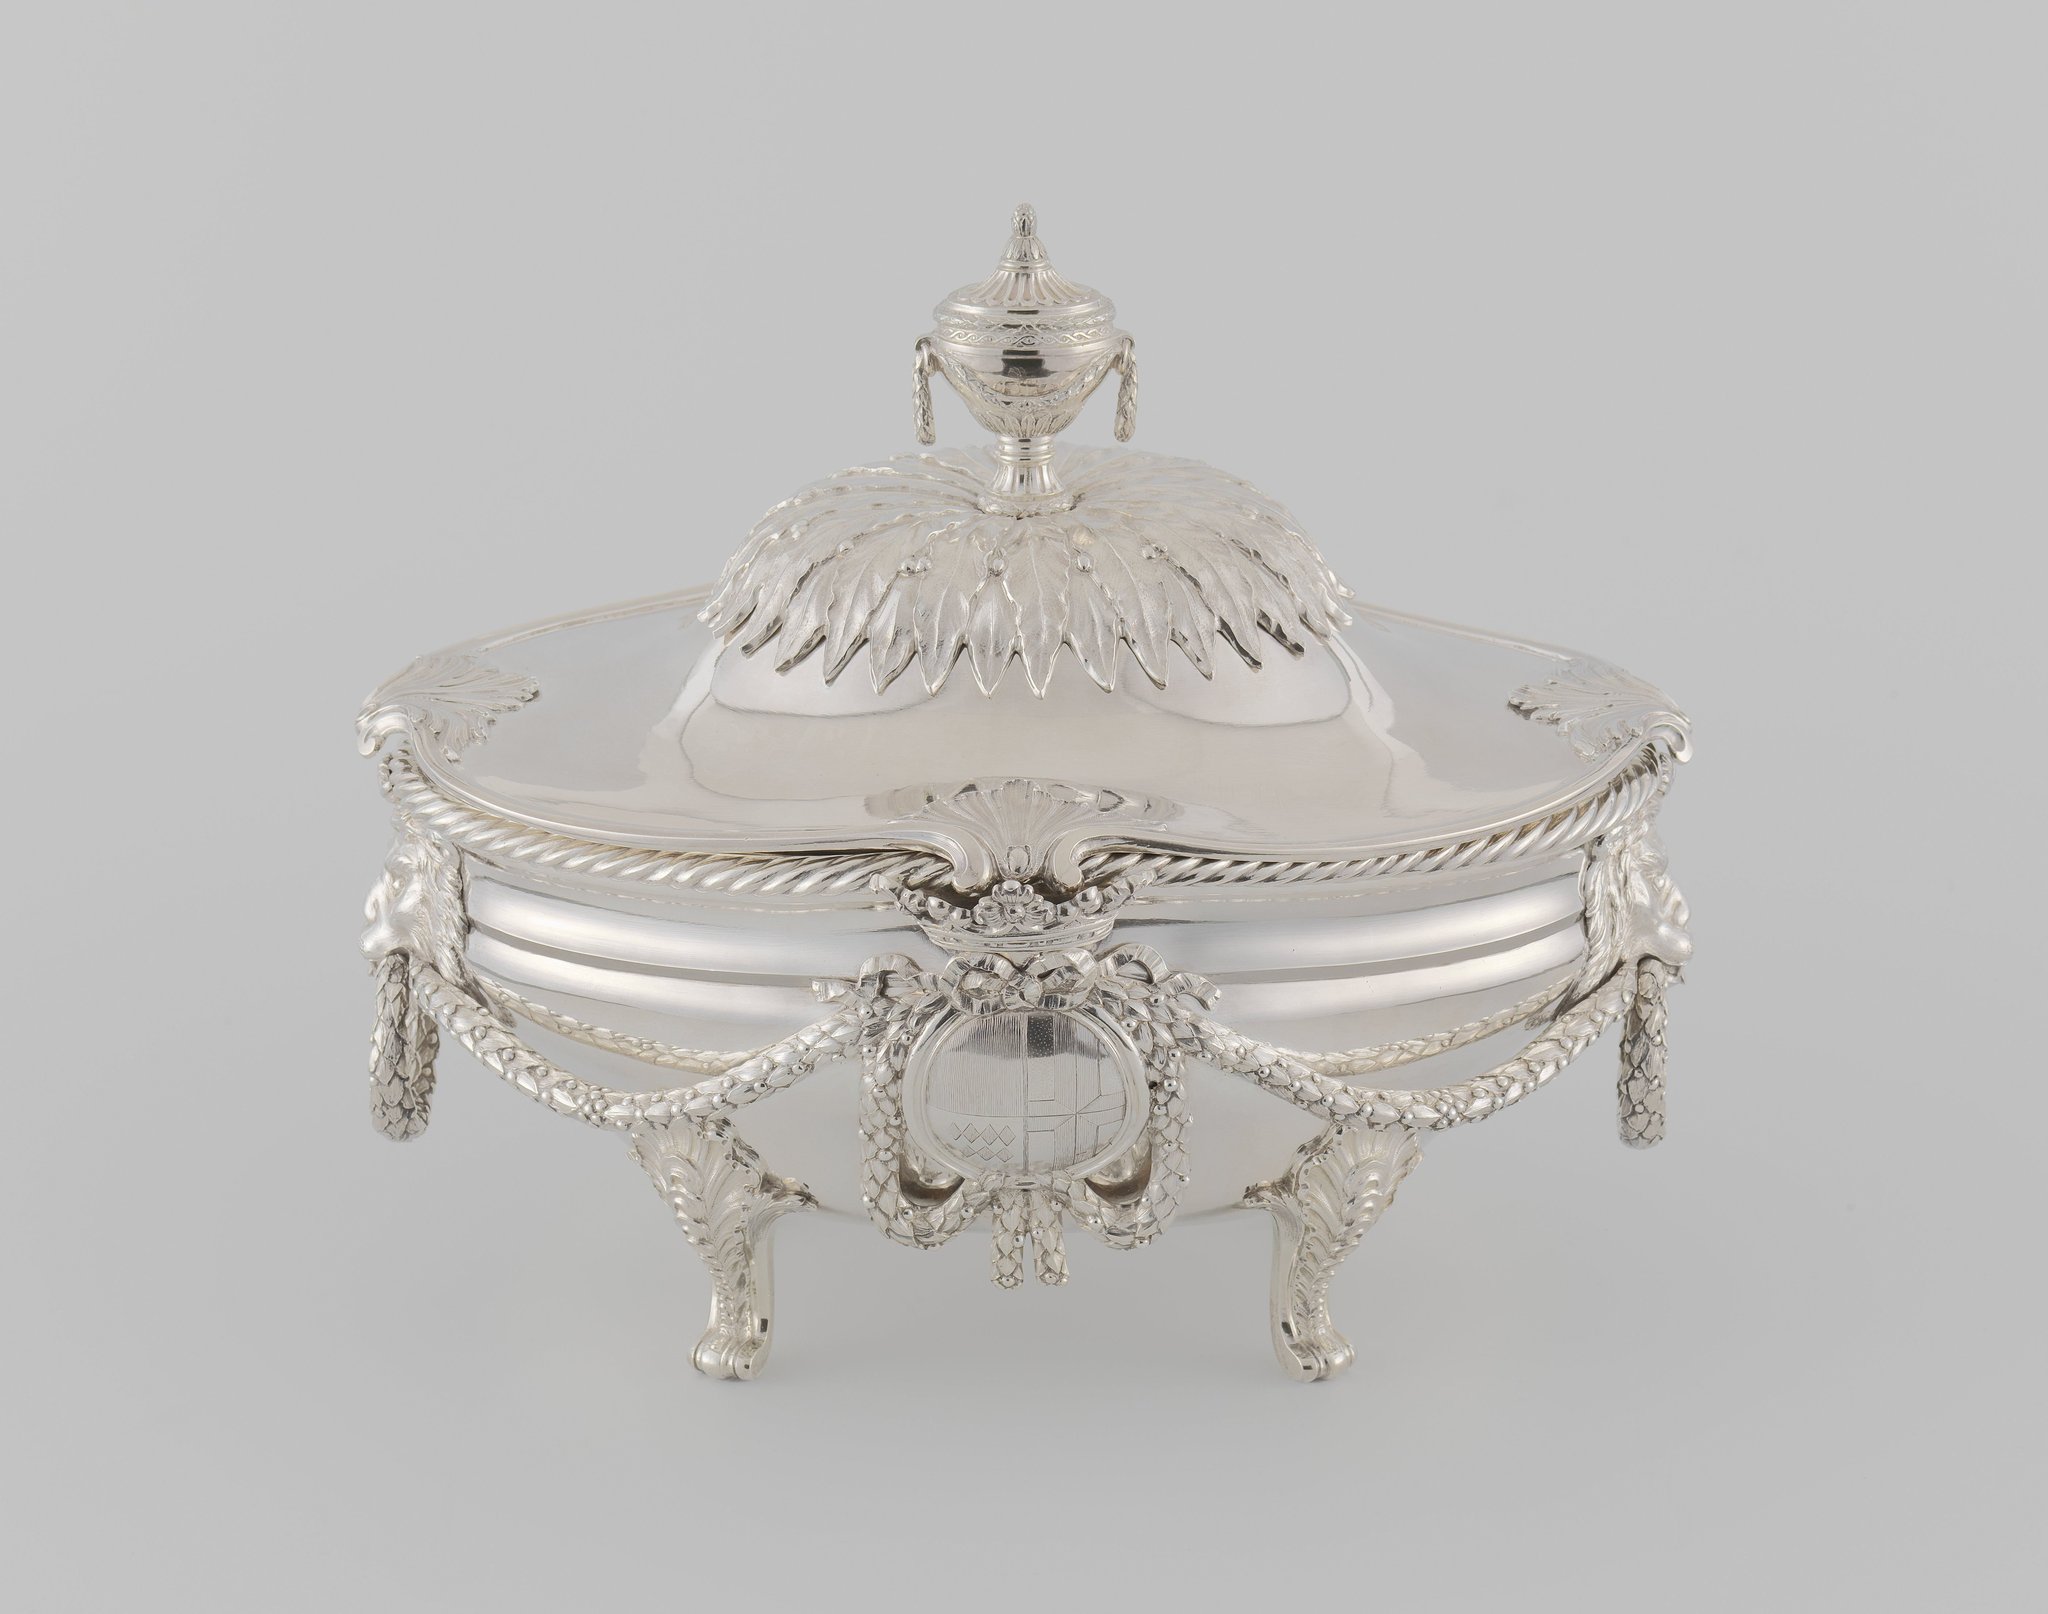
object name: tureen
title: Tureen and stand with a ladle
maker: engelbart joosten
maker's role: silversmith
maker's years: 1717-1789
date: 1772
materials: silver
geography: the hague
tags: ornament ~ festoon, garland, armorial bearing, heraldry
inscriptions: inscription: ‘Op terrine, onderschotel en lepel de gecombineerde wapens gegraveerd van: Assueer Jan baron Torck, heer van Rosendael, Duivenvoorde, Petkum, Harselo, Voorschoten, Veur en Eusebia Jacoba de Rode van Heeckeren.’, signature and date: ‘Merken: Den Haag; kl. leeuw (tweede gehalte); jrl. A (1772); mt. E. Joosten.’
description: This tureen and stand bear the alliance coat of arms of Baron Assueer Jan Torck and Eusebia Jacoba de Rode van Heeckeren, who were married in 1758. This couple was closely acquainted with the stadtholder and his consort. The imposing tureen, an early example of Neoclassical Hague silver, affords a good impression of the art at and around the stadtholder’s court.